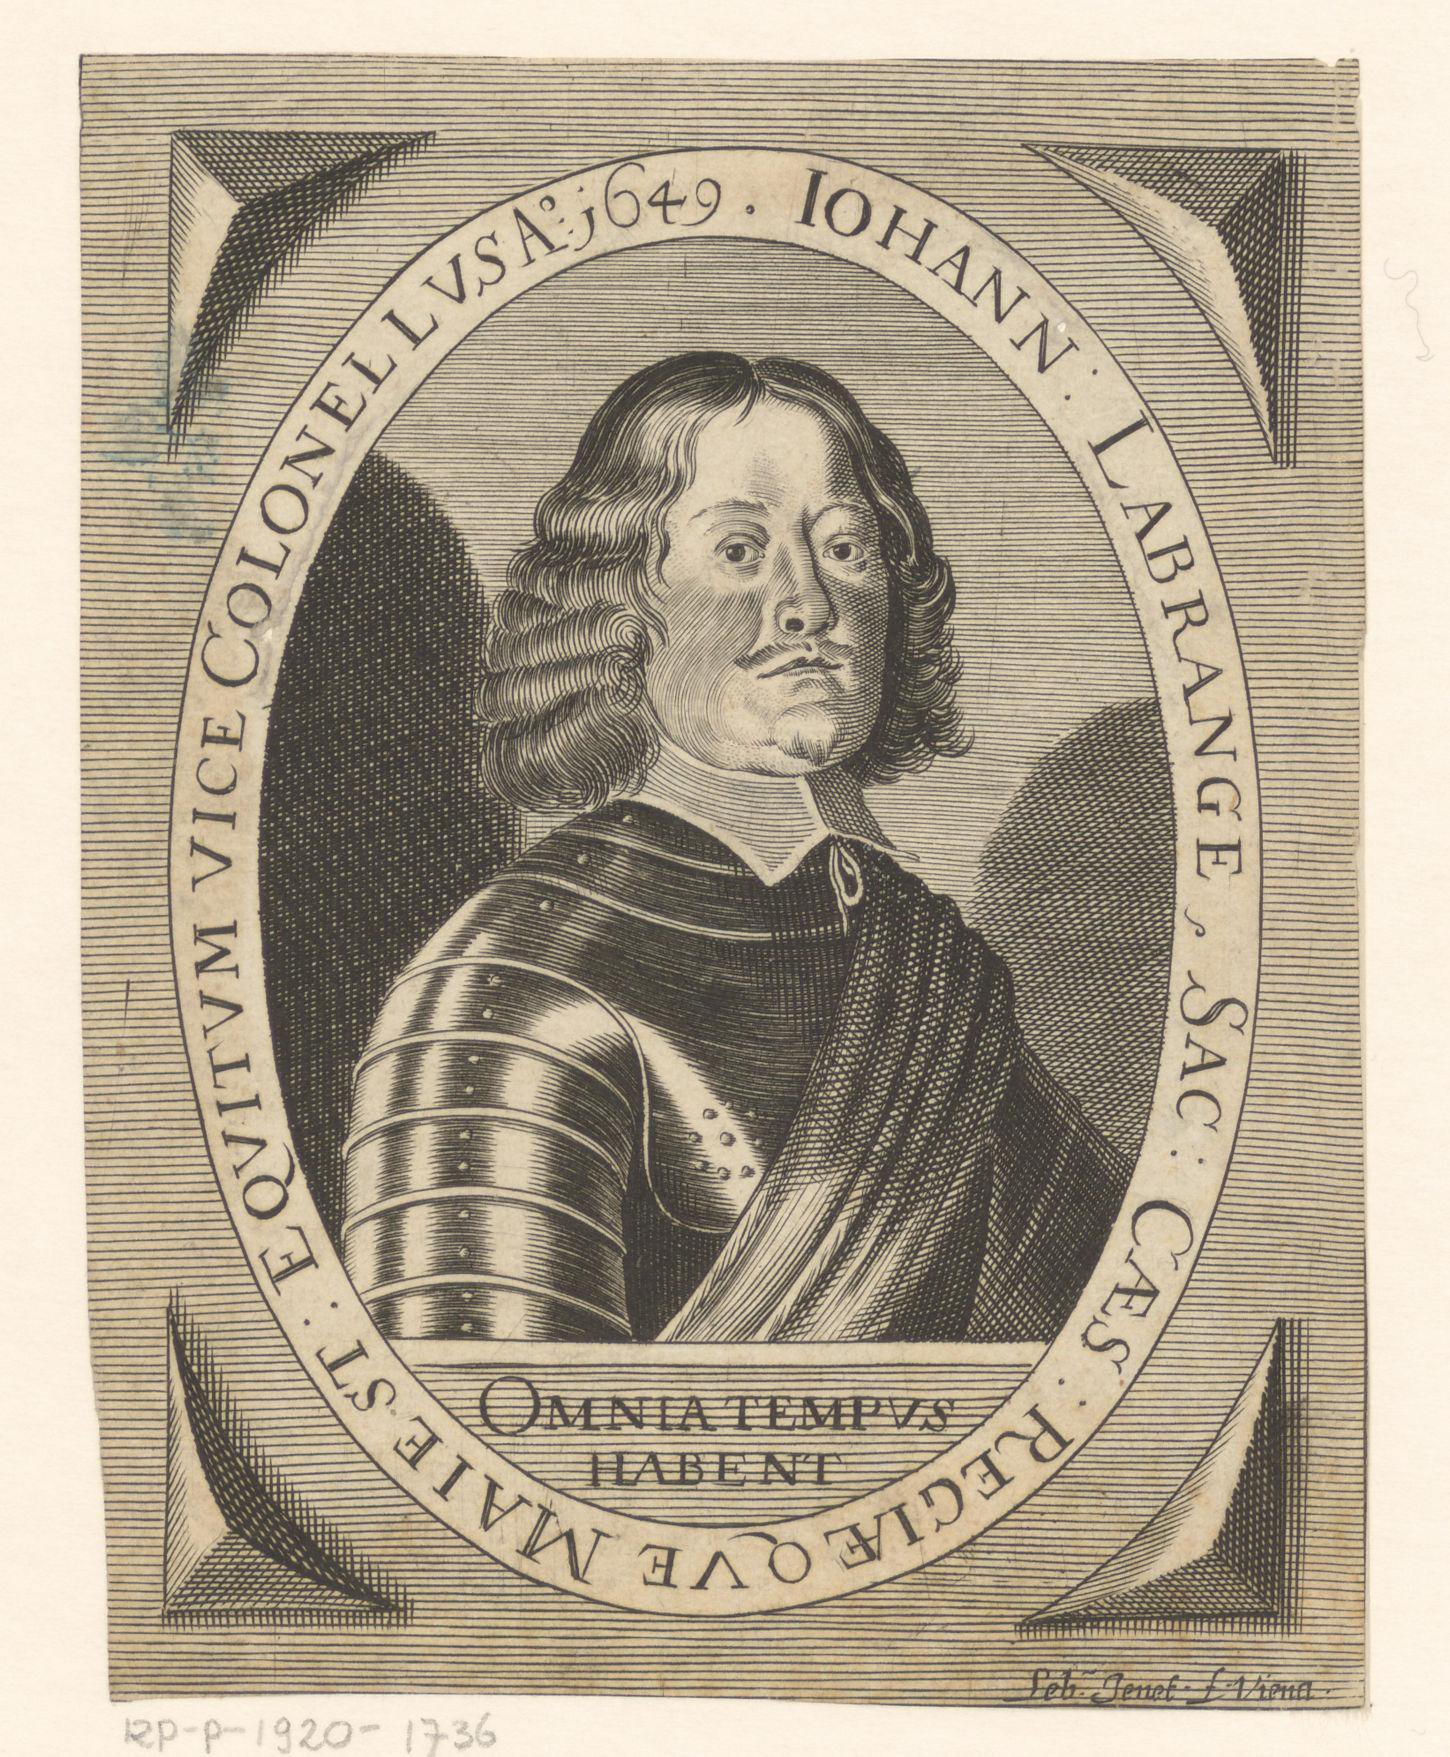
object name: print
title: Portret van Johann Labrange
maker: sebastian jenet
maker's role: draughtsman, print maker, publisher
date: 1649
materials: paper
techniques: engraving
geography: vienna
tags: historical persons, officer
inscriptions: collector's mark: Lugt 2228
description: Deze prent maakt deel uit van een serie van achttien portretten voor: Widemann, Elias. Comitium Gloriae Centum Qua Sanguine Qua Virtute Illustrium Heroum Iconibus Instructum Et Excelmo. Ac Illustrissimo Heroi D.D. Joanni Christophoro Com: a Puchaim (...) Dicatum. Wenen: Matthaeus Cosmerovius, 1650.